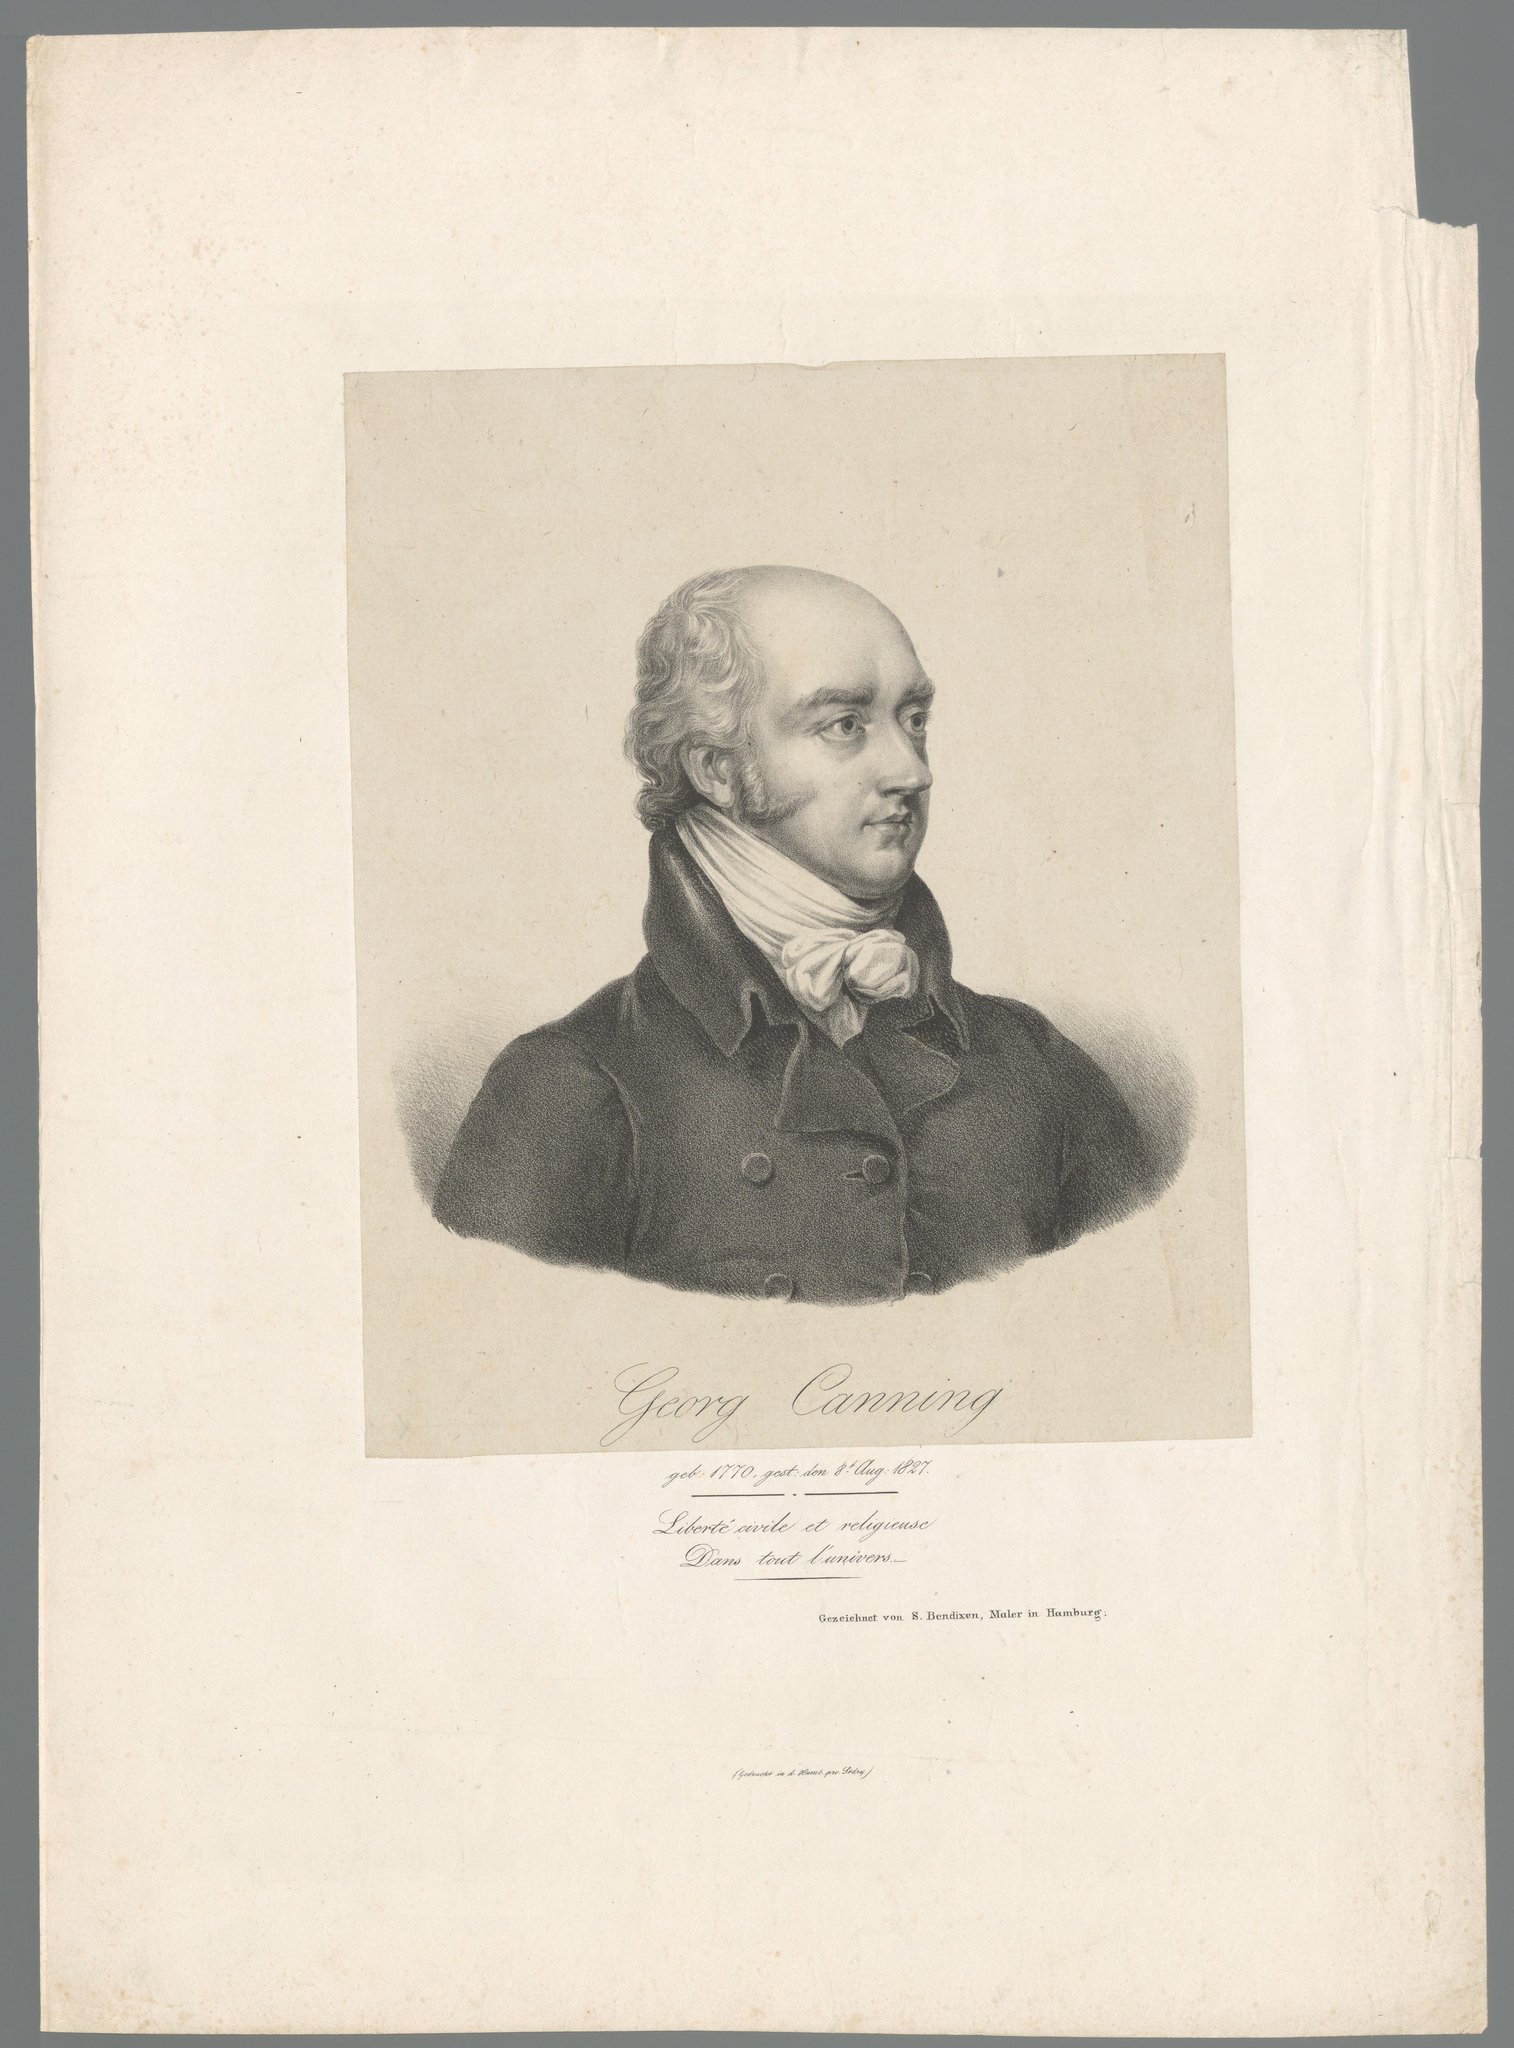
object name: print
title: Portret van George Canning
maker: Anonymous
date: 1796-1864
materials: paper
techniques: lithograph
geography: hamburg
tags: london, adult man, historical persons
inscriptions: collector's mark: Lugt 2228